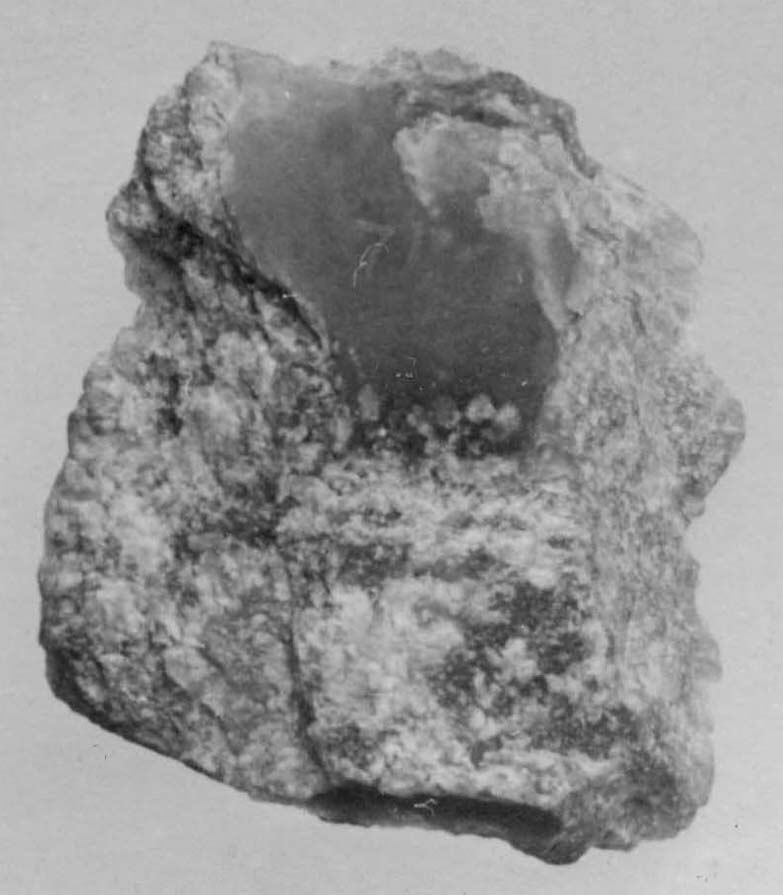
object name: fragment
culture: chinese or turkestani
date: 1902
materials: jade